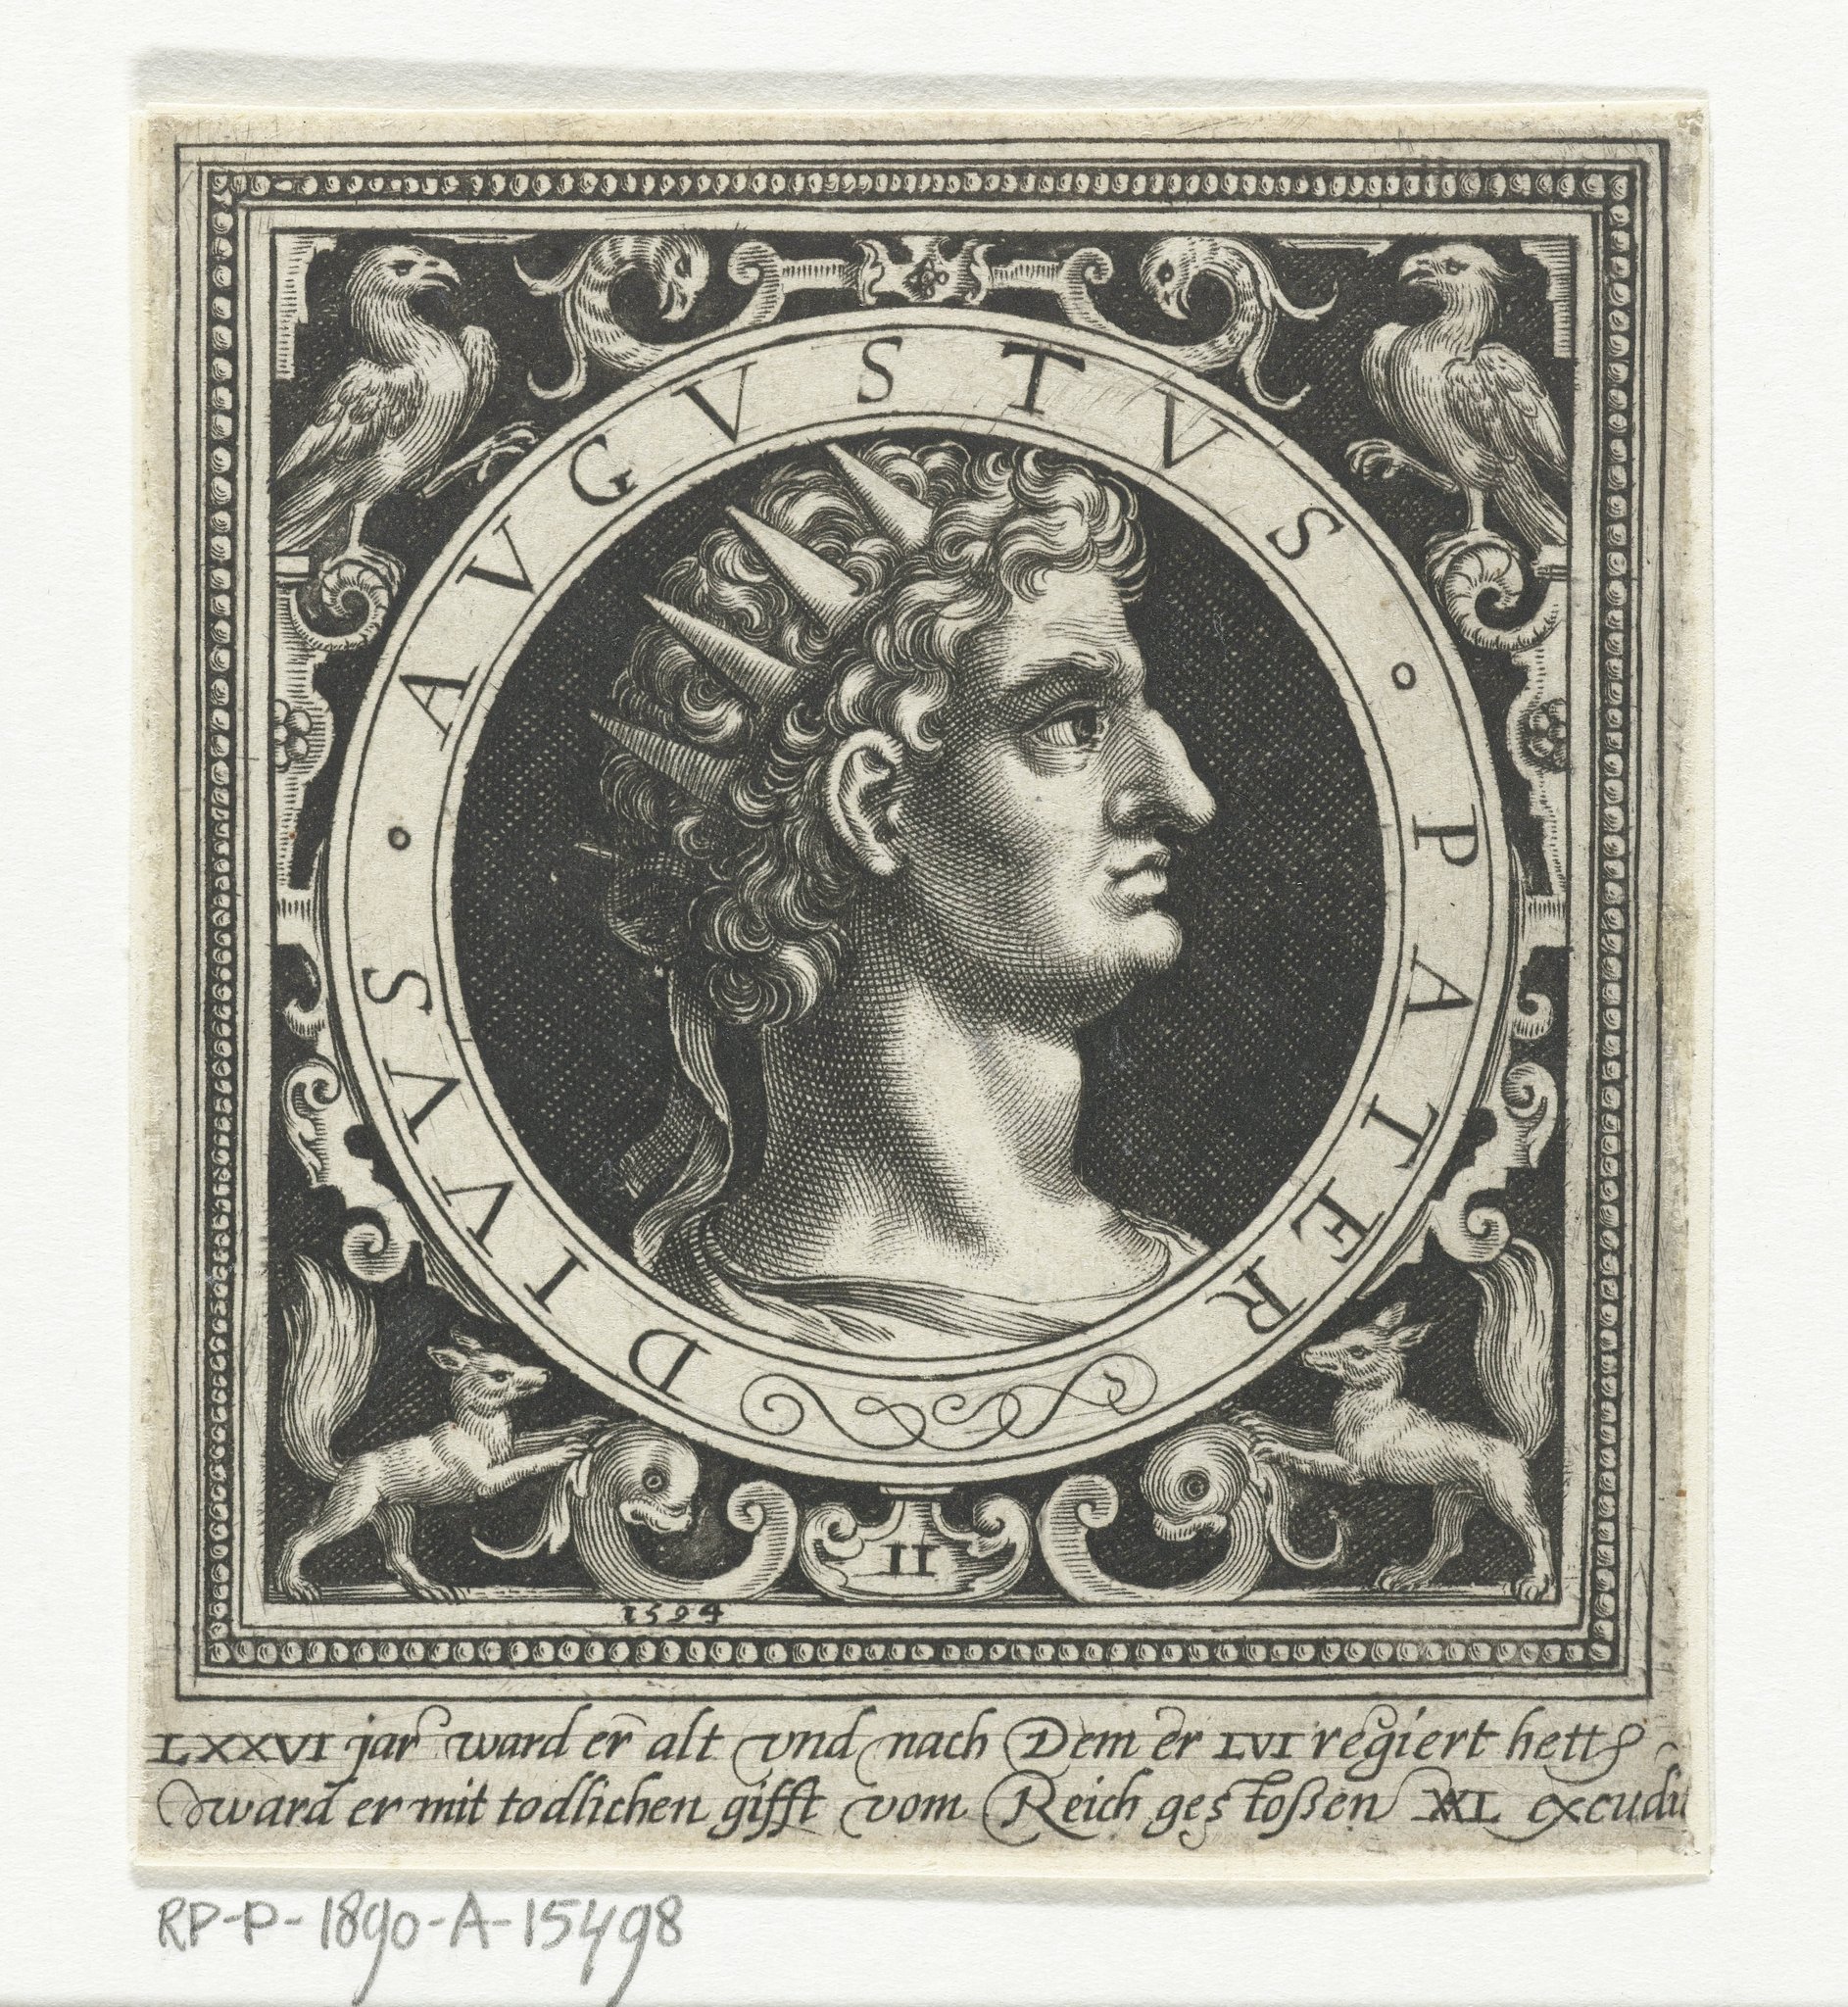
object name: print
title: Romeinse keizers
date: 1594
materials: paper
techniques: engraving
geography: netherlands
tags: (story of) augustus, the roman emperor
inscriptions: collector's mark: Lugt 2228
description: Portret met buste van keizer Augustus op medaillon in rechthoekige omlijsting met ornamenten. Op rand van medaillon titel en naam van keizer. In de marge onder twee regels in Duits over de wijze waarop de keizer om het leven kwam.